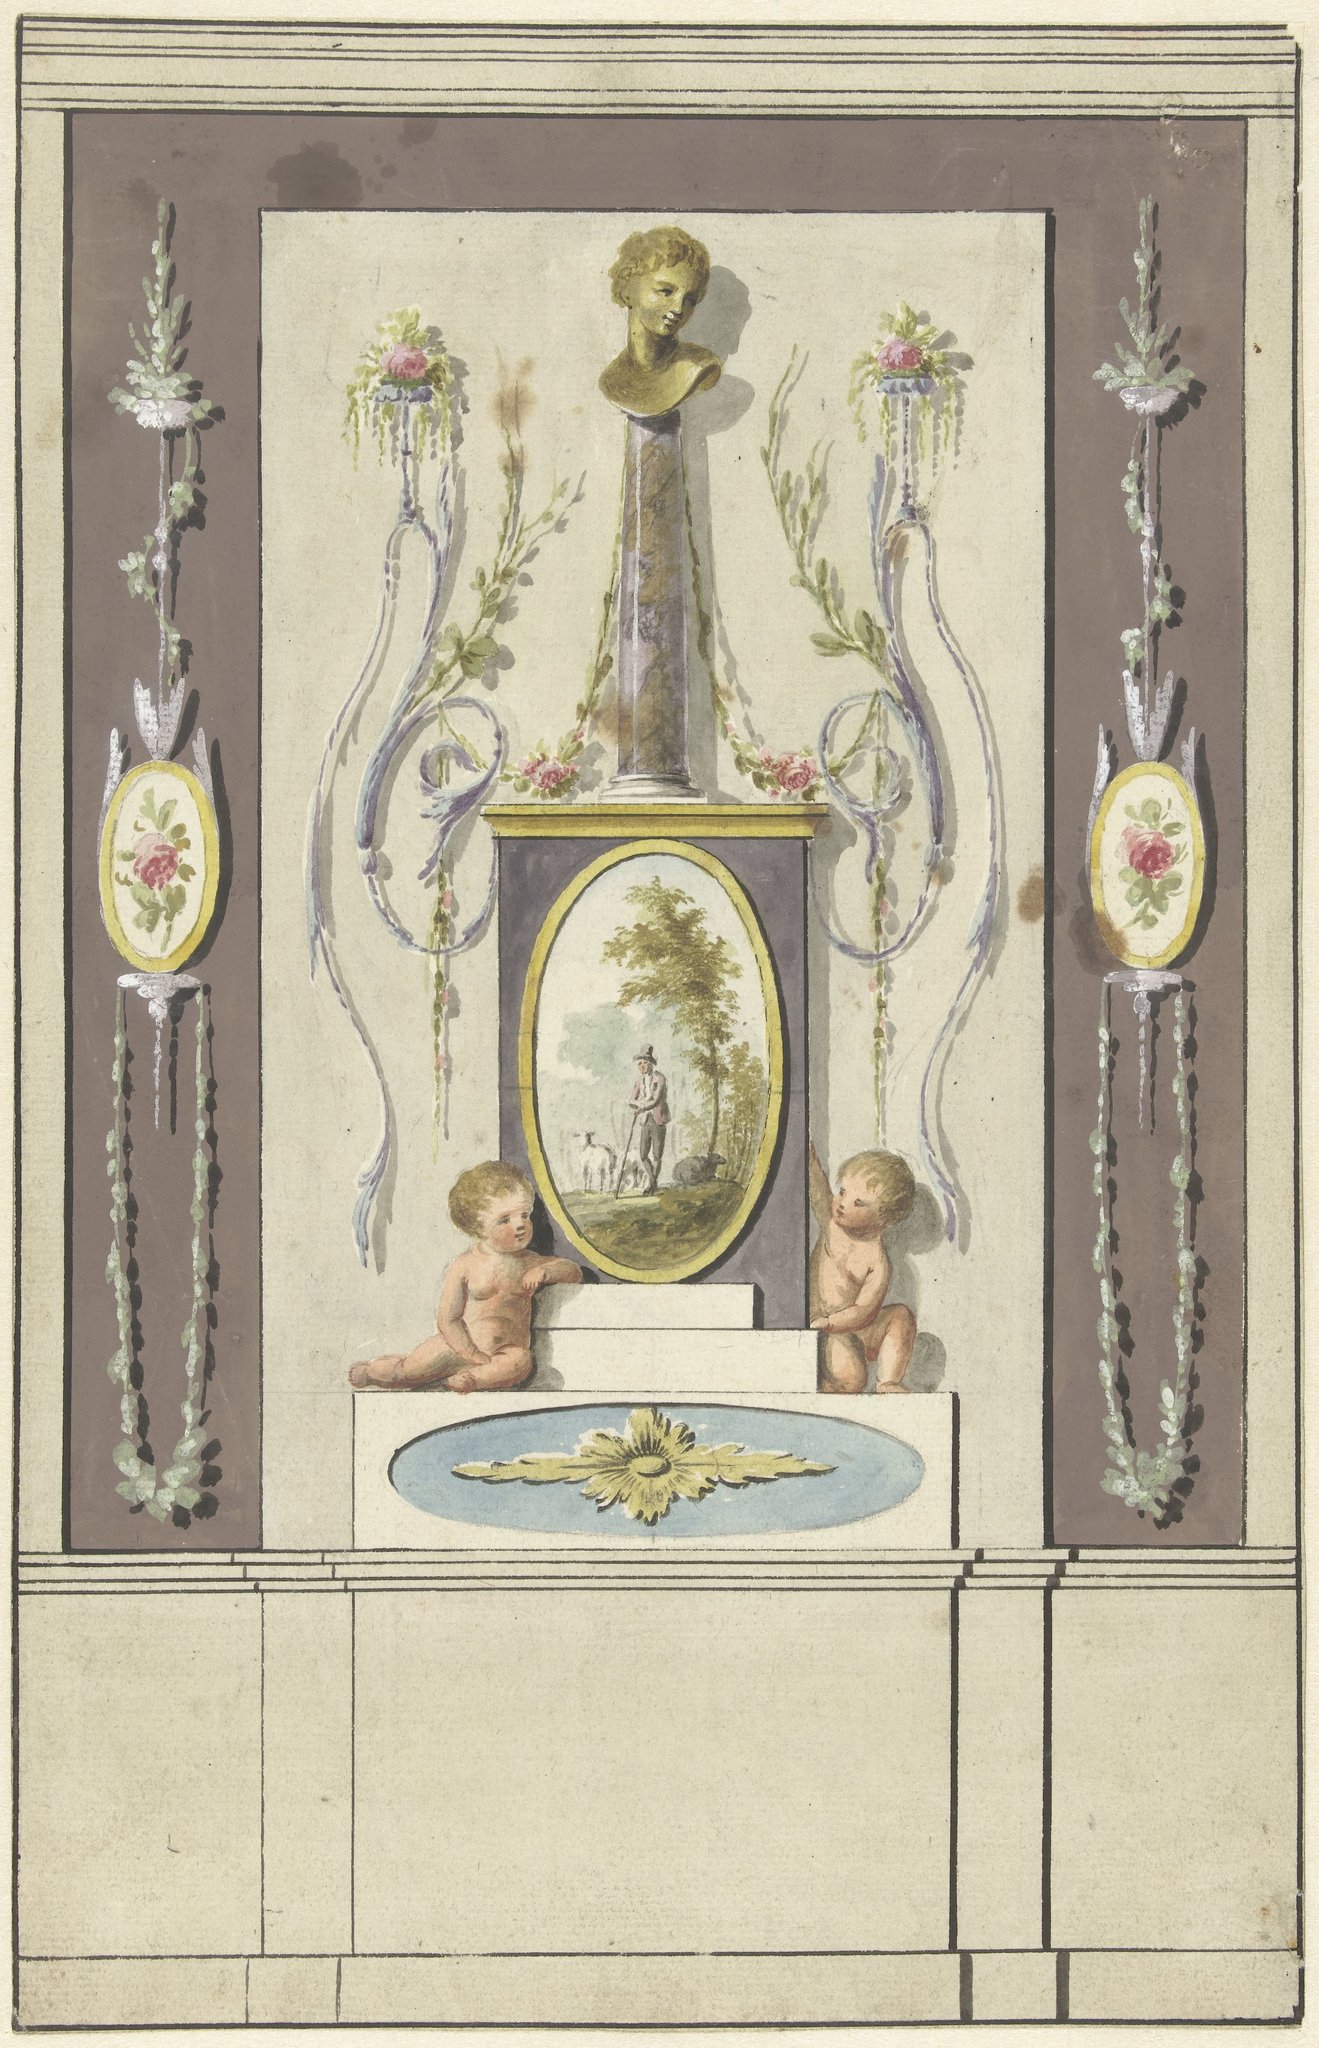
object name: drawing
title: Ontwerp voor kamerversiering met een paneel met een buste op een zuil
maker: abraham meertens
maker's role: draughtsman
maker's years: 1757-1823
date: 1767-1823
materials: paint, ink, paper, pencil, watercolor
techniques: brush, pen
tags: wall-covering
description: Ontwerp voor kamerversiering met een paneel met een buste op een zuil, een medaillon met herder en twee putti. Ontwerp voor een wanddecoratie.